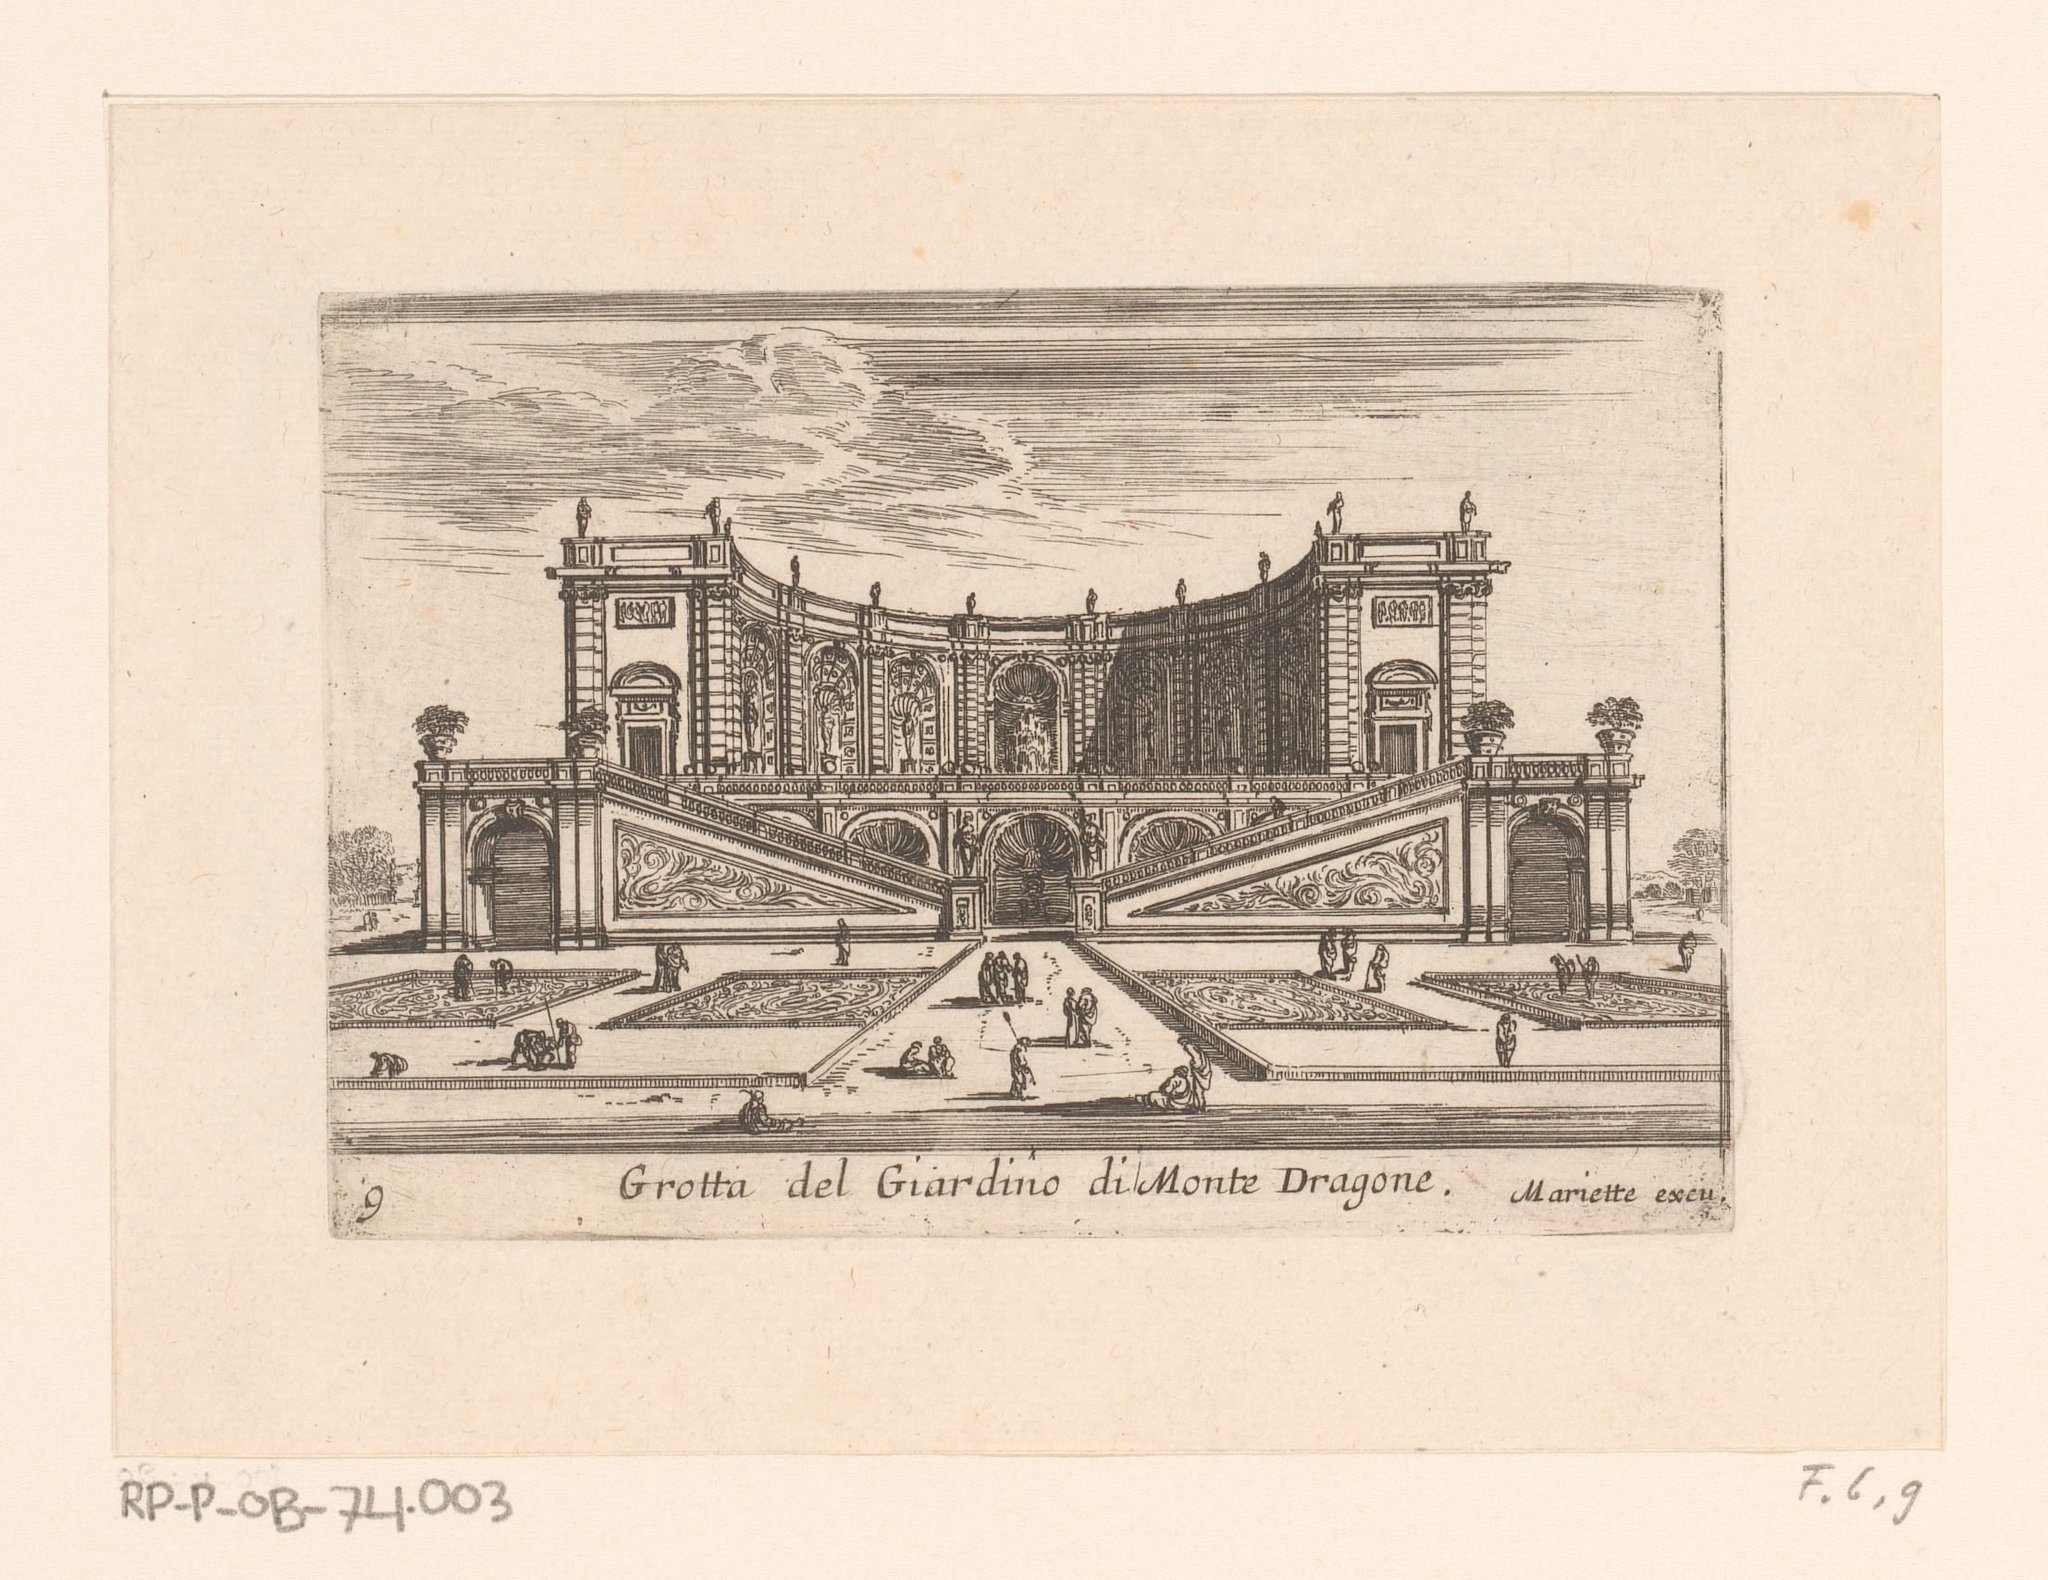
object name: print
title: Gezicht op de grotto in de tuin van Villa Mondragone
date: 1646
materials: paper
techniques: etching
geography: paris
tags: french or architectonic garden; formal garden, artificial grotto in garden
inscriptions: collector's mark: Lugt 240